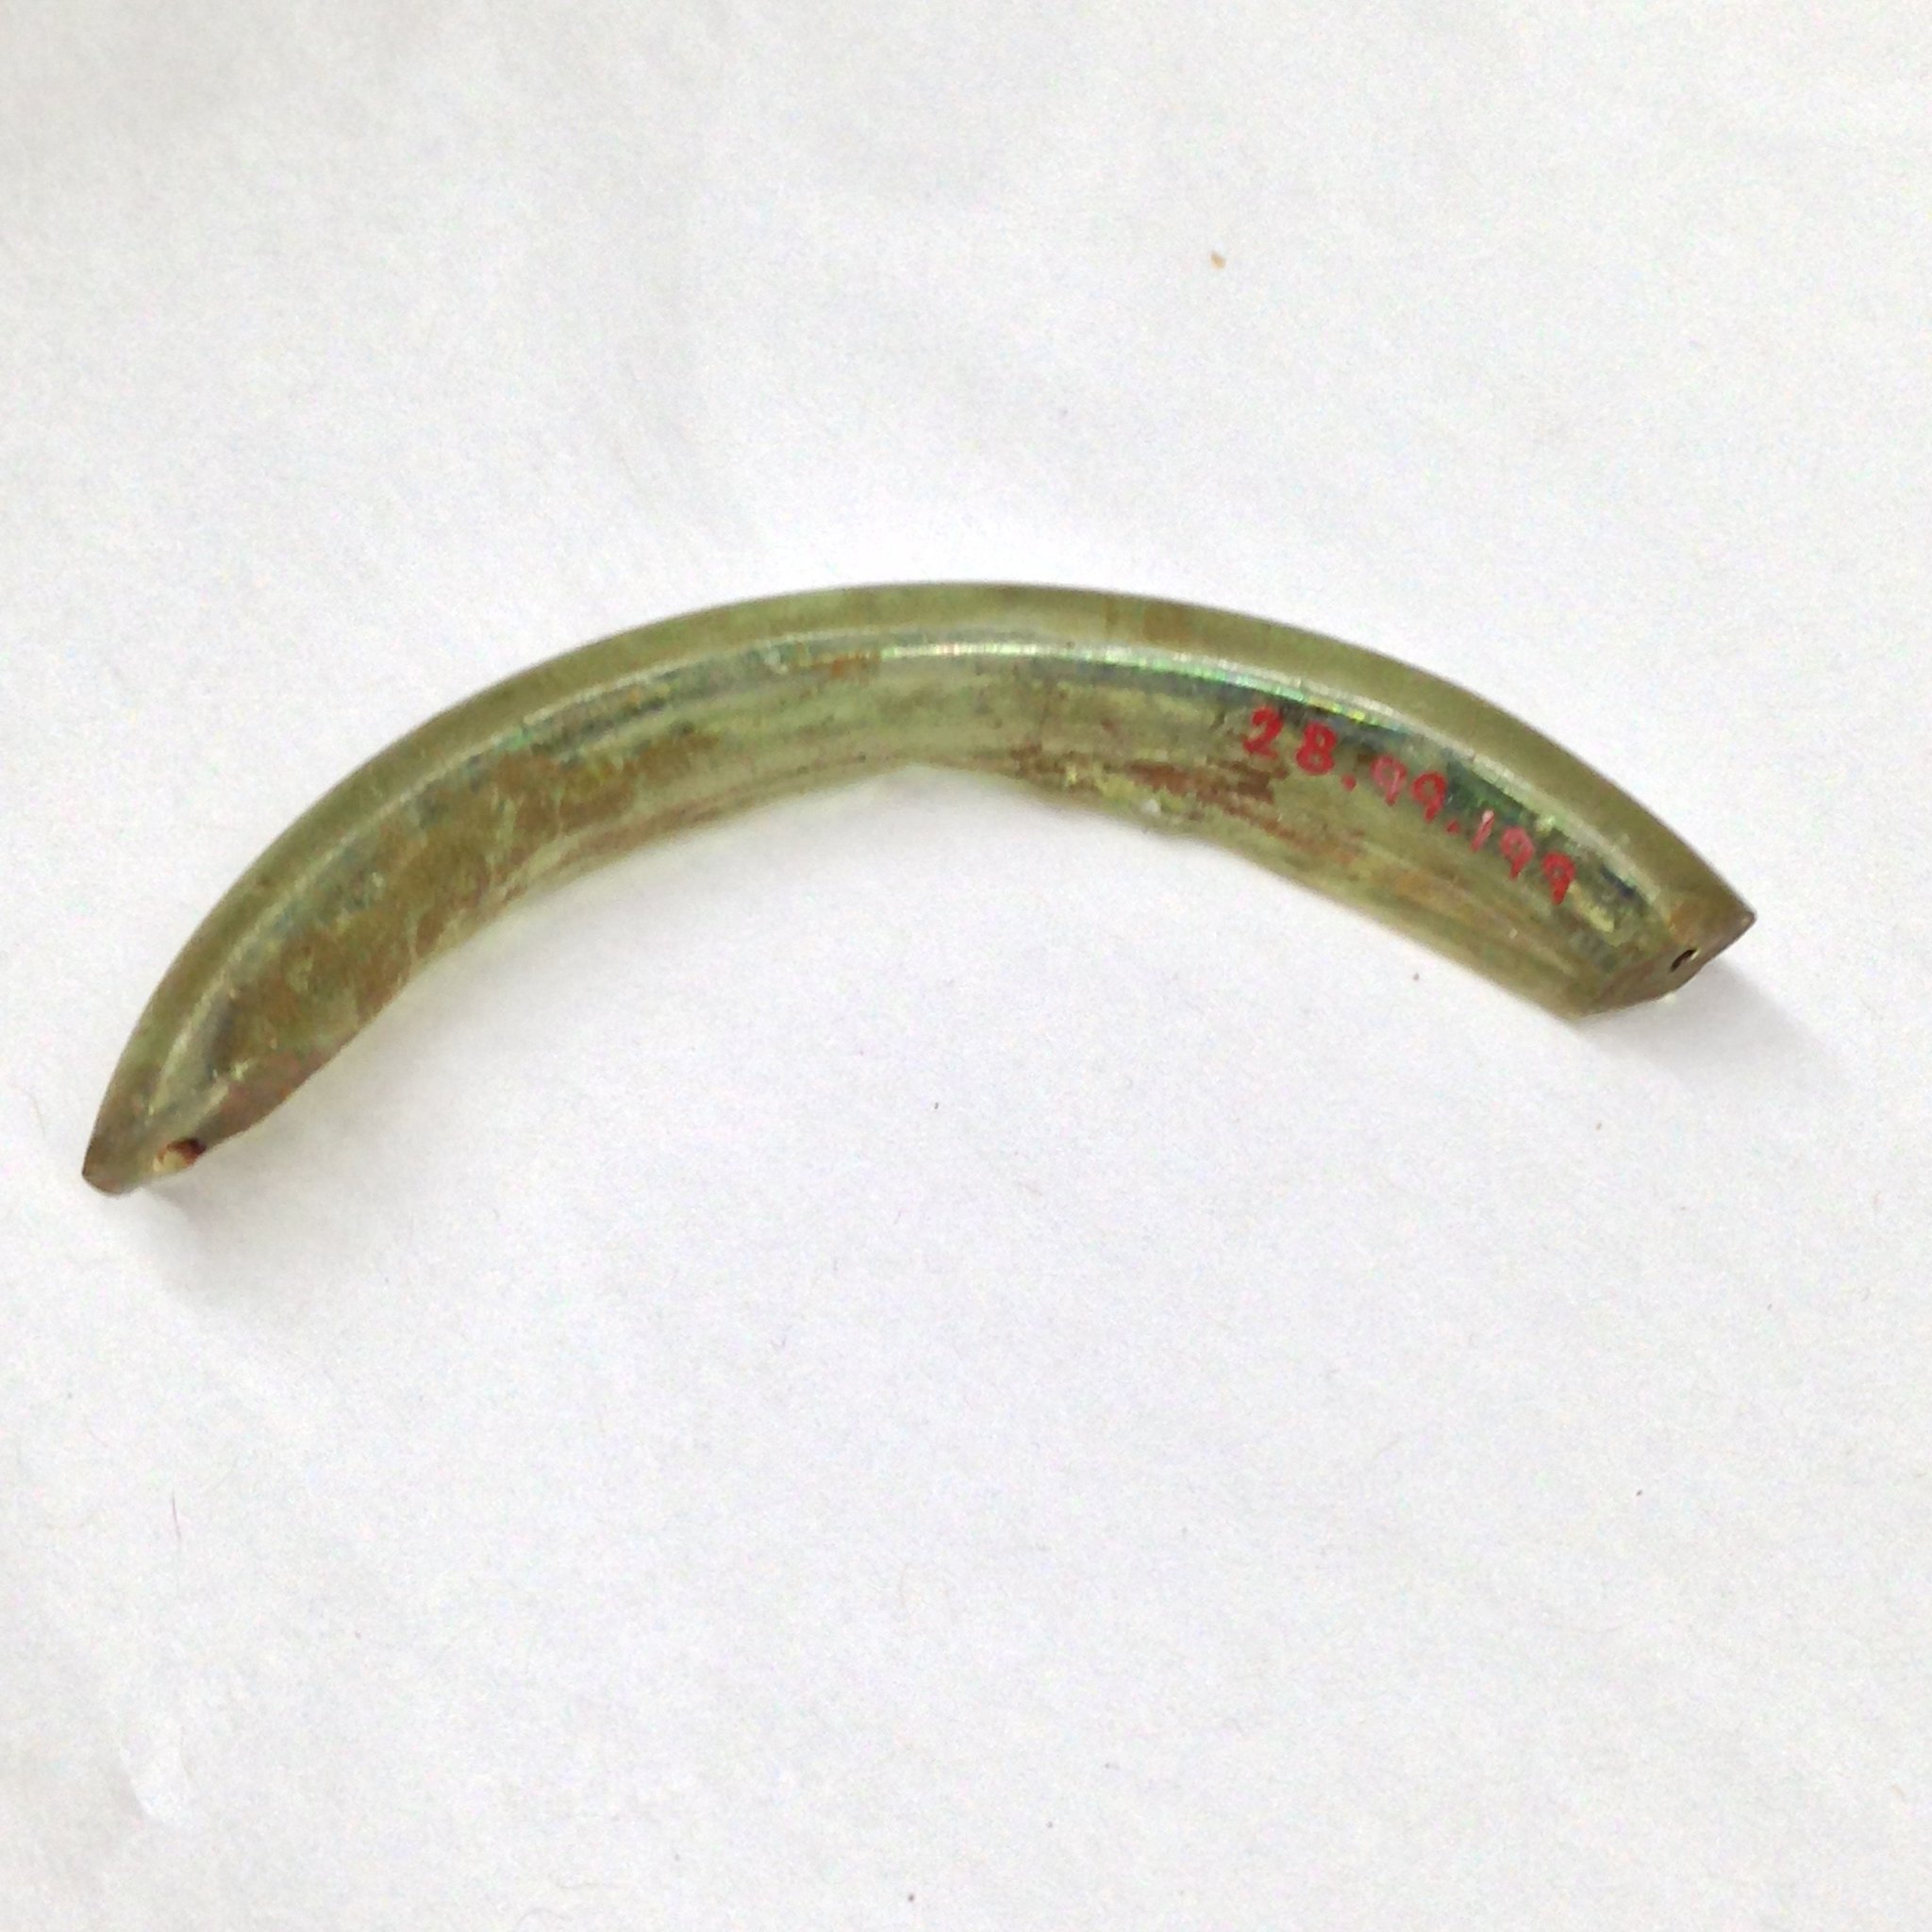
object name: fragment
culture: european or middle eastern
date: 1150-1250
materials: ceramic, glass